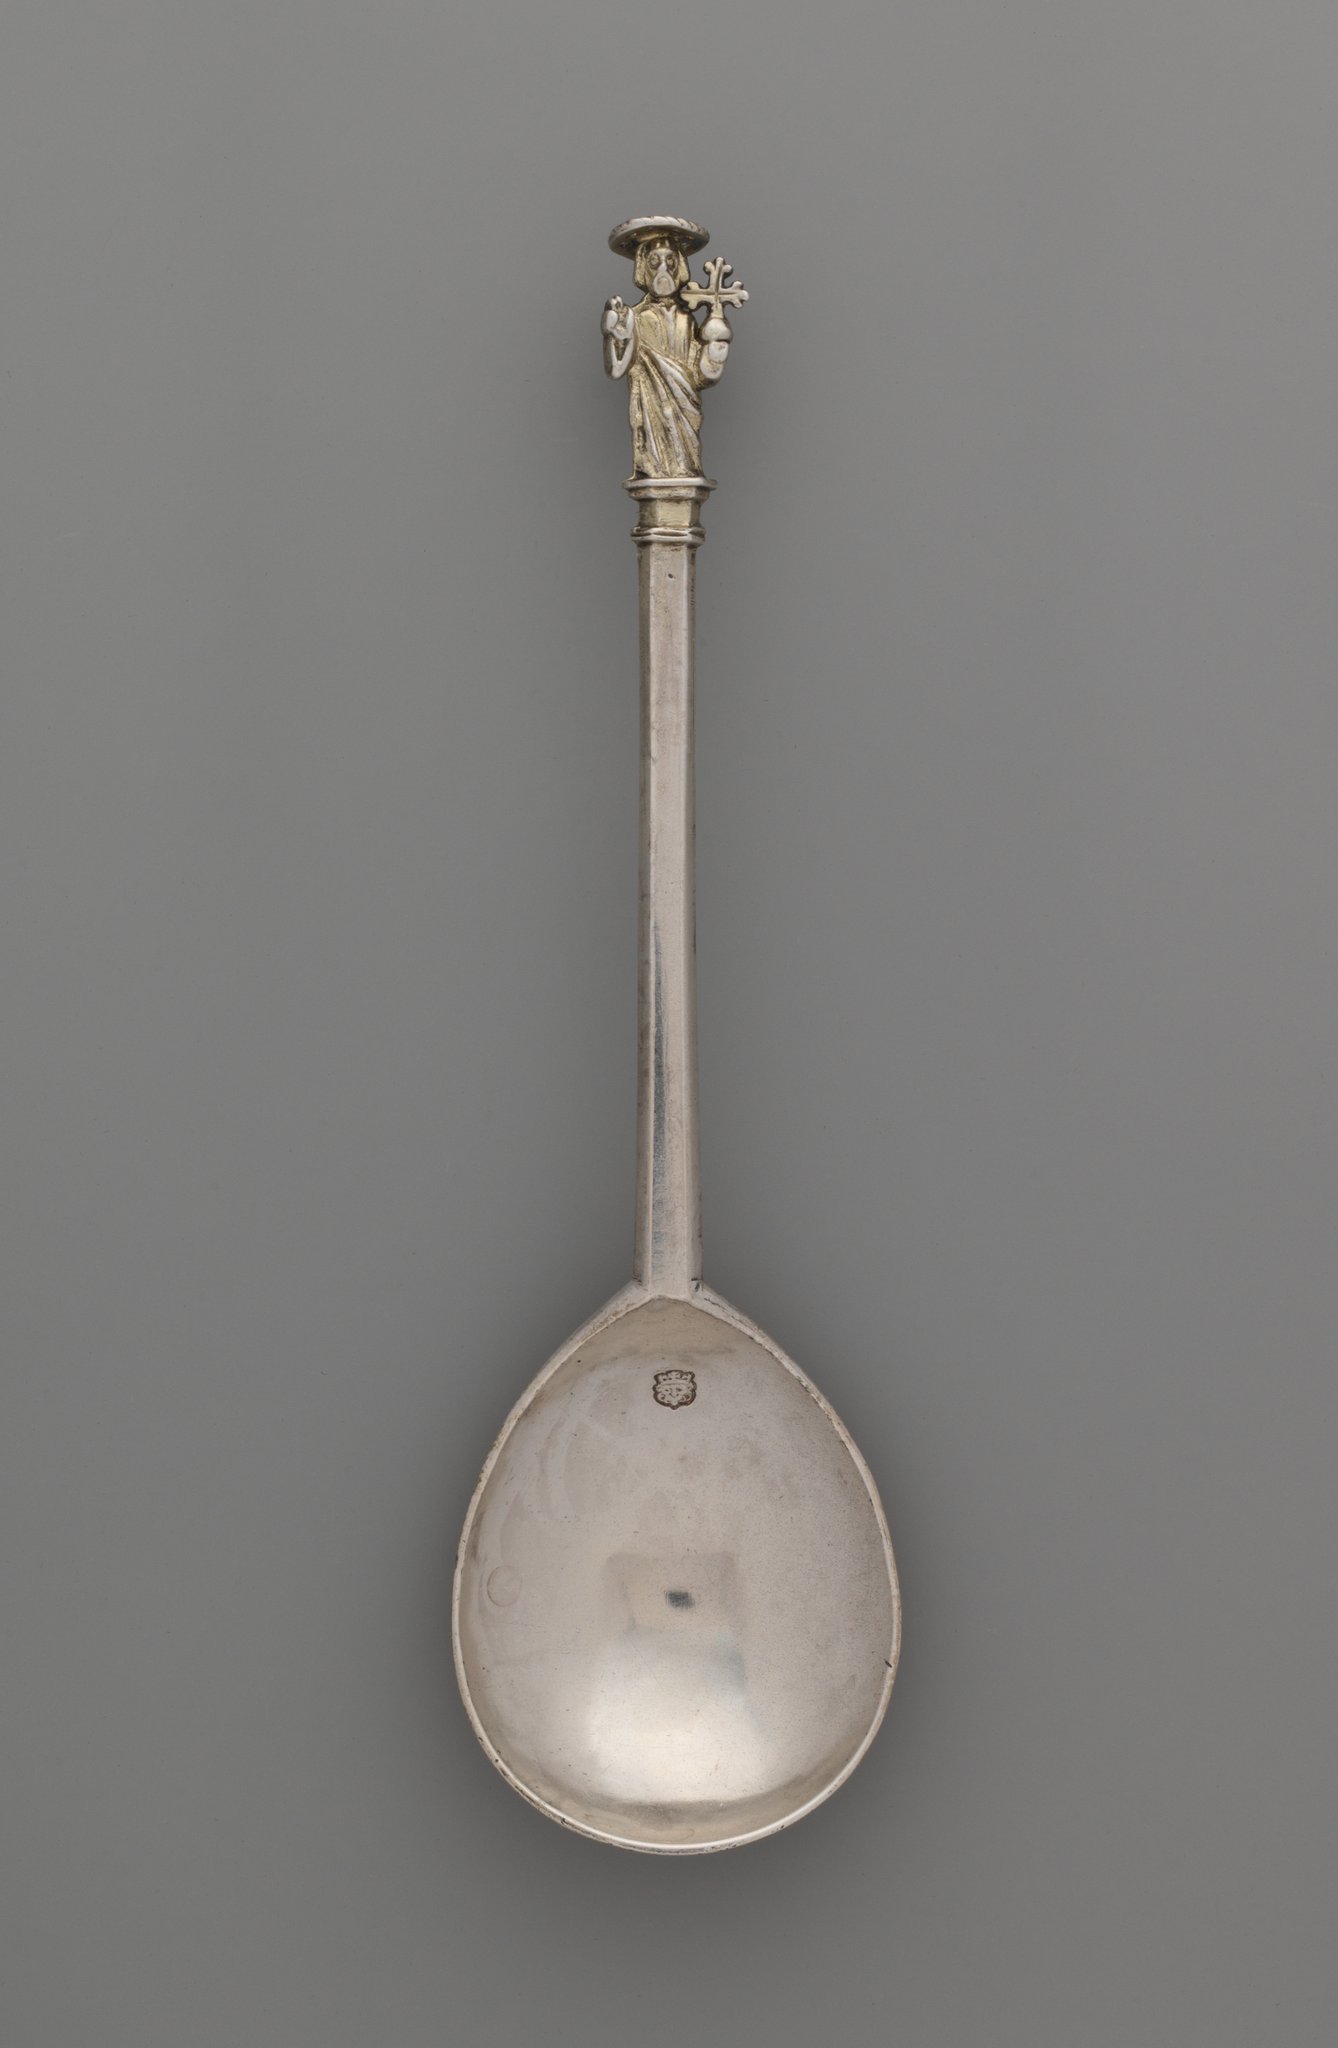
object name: apostle spoon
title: Apostle spoon: Master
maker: william cawdell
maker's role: maker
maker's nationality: british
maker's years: 1560-1625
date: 1592-1593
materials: silver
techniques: gilding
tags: christ,cross